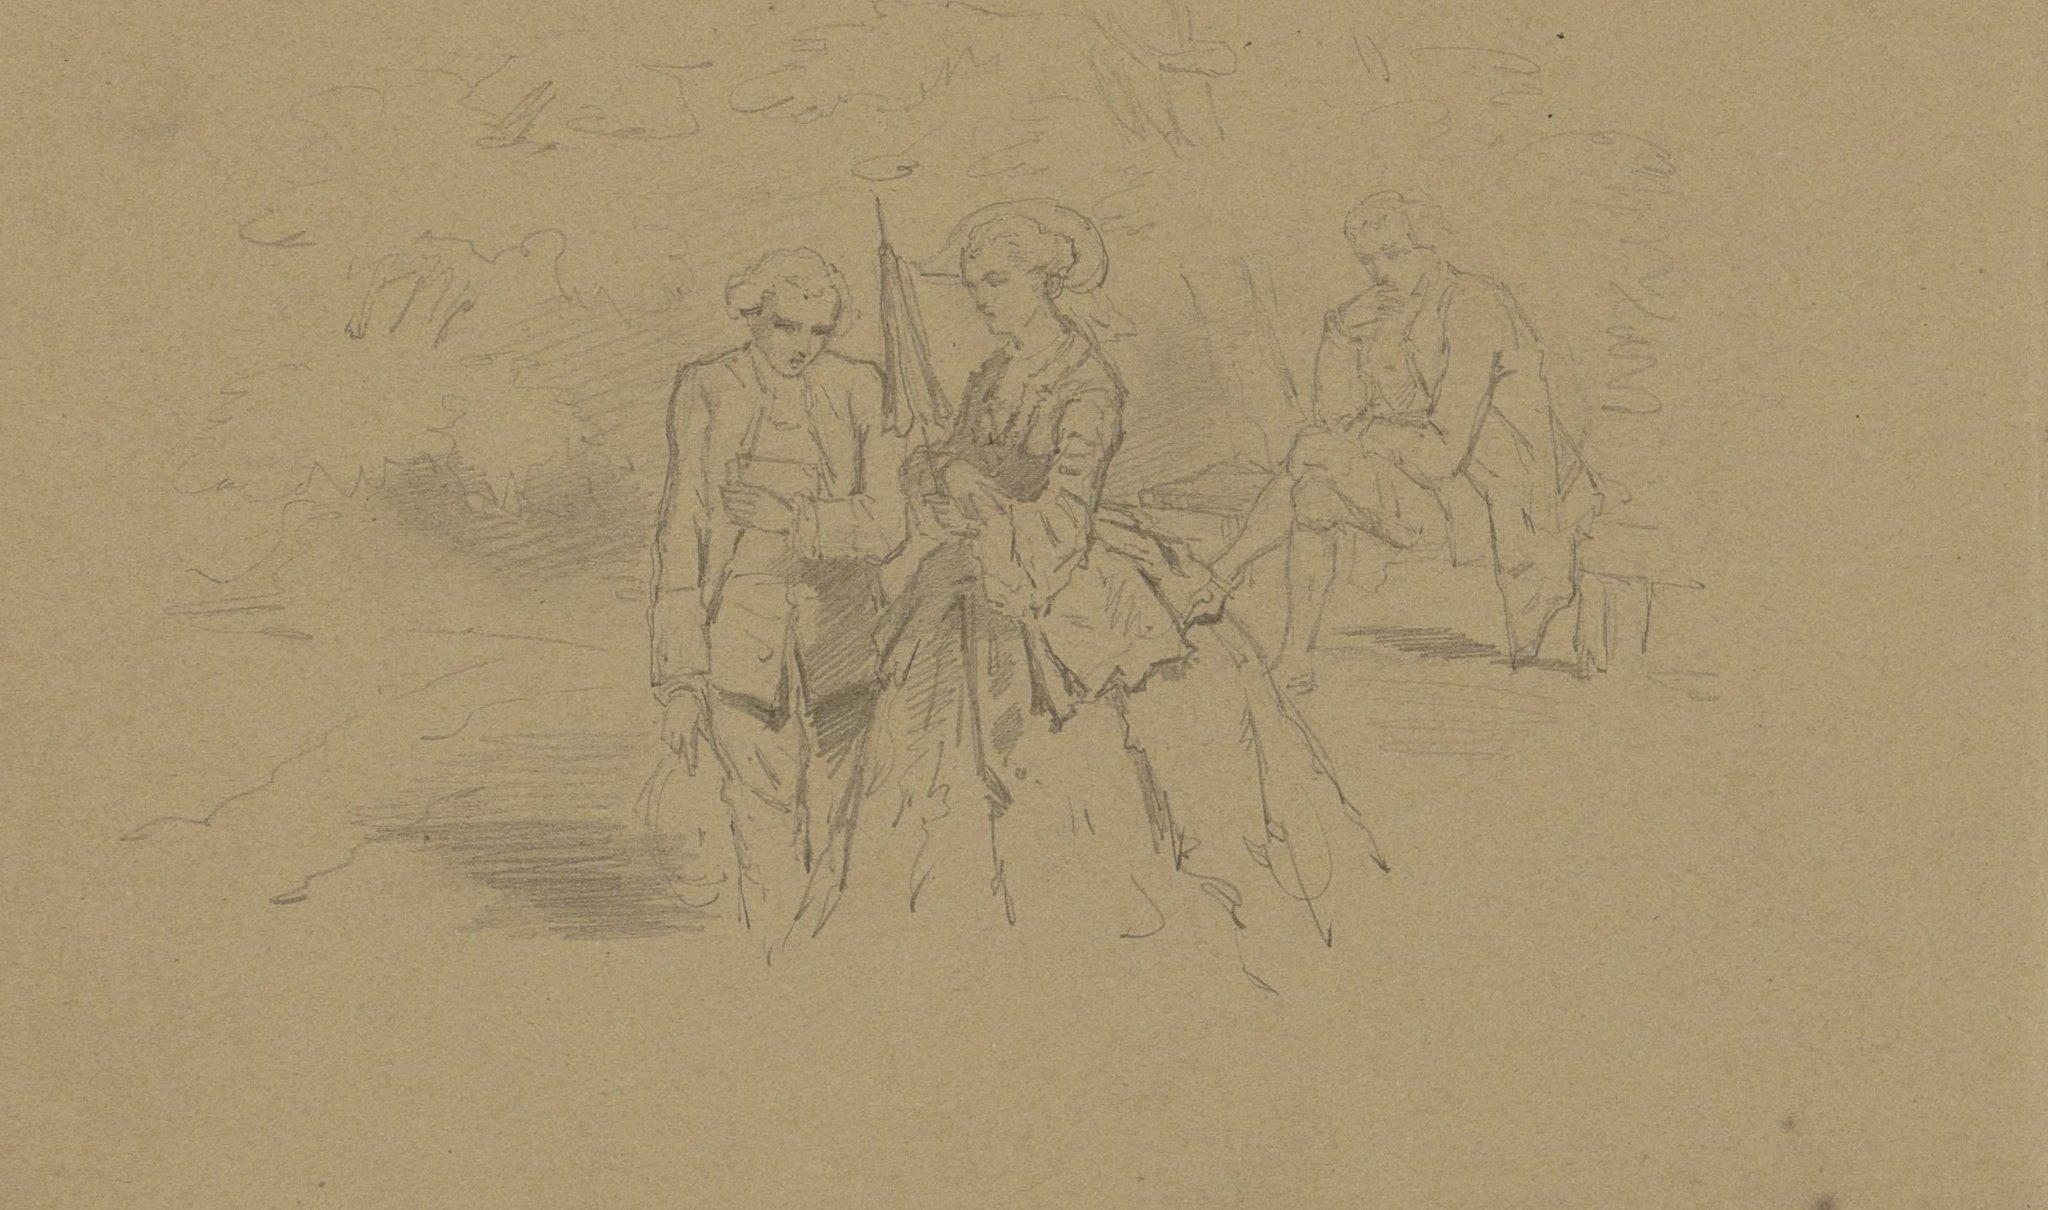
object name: sketchbook leaf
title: Wandelend paar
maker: charles rochussen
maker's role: draughtsman, painter, print maker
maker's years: 1814-1894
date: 1840-1860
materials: paper, pencil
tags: walking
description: De vrouw draagt een parasol en de man houdt een document voor de borst. Op de achtergrond zit een man op een bank in een peinzende houding. Blad 29 verso uit een schetsboek met 38 bladen.